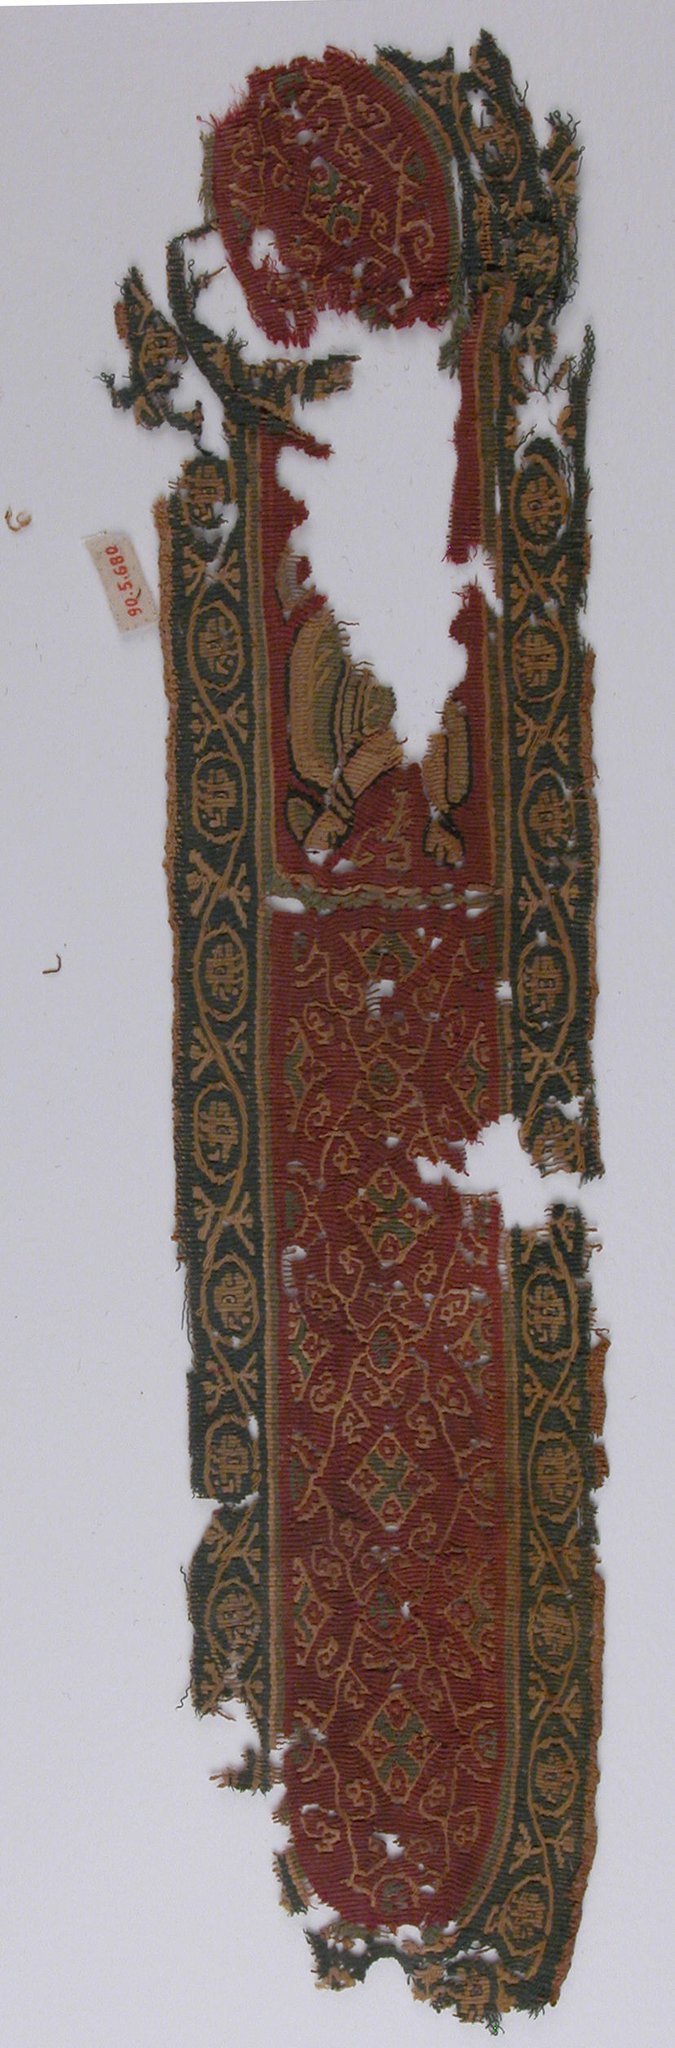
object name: textile fragment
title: Fragment of Shoulder Band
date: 601-800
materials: linen, wool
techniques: weave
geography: egypt